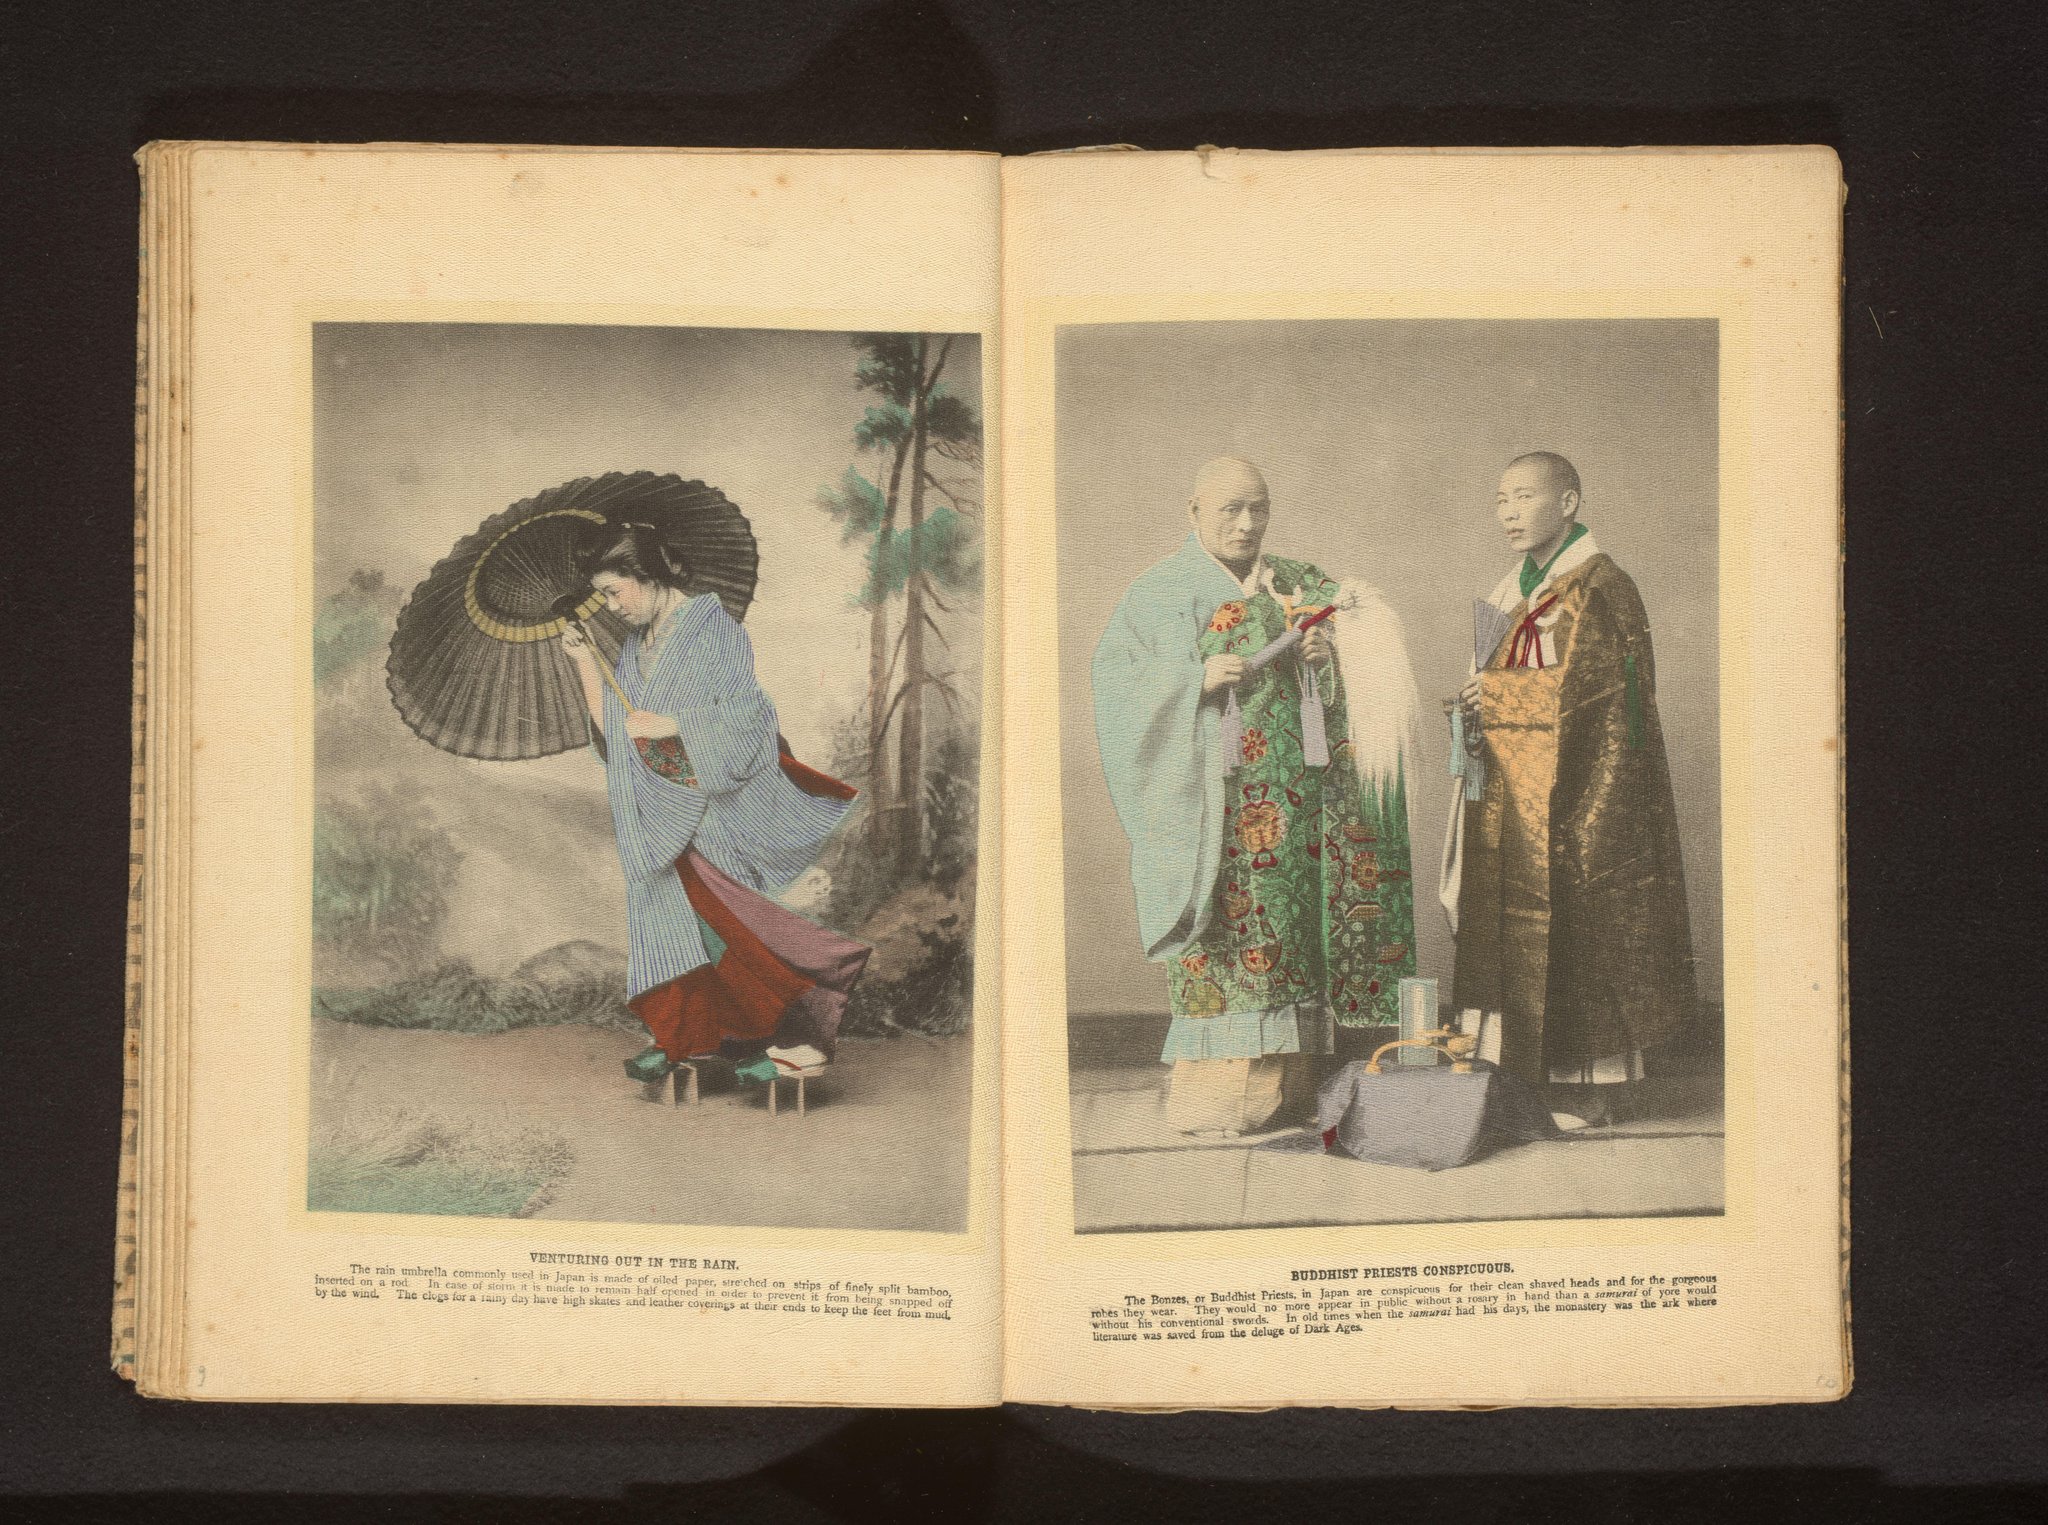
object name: page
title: Venturing out in the rain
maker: kazumasa ogawa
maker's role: auteur, fotograaf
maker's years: 1860-1929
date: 1886-1896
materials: paper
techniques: photograph, hand coloring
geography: japan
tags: adult woman, umbrella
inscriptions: inscription: ‘The rain umbrella (...) feet from mud.’